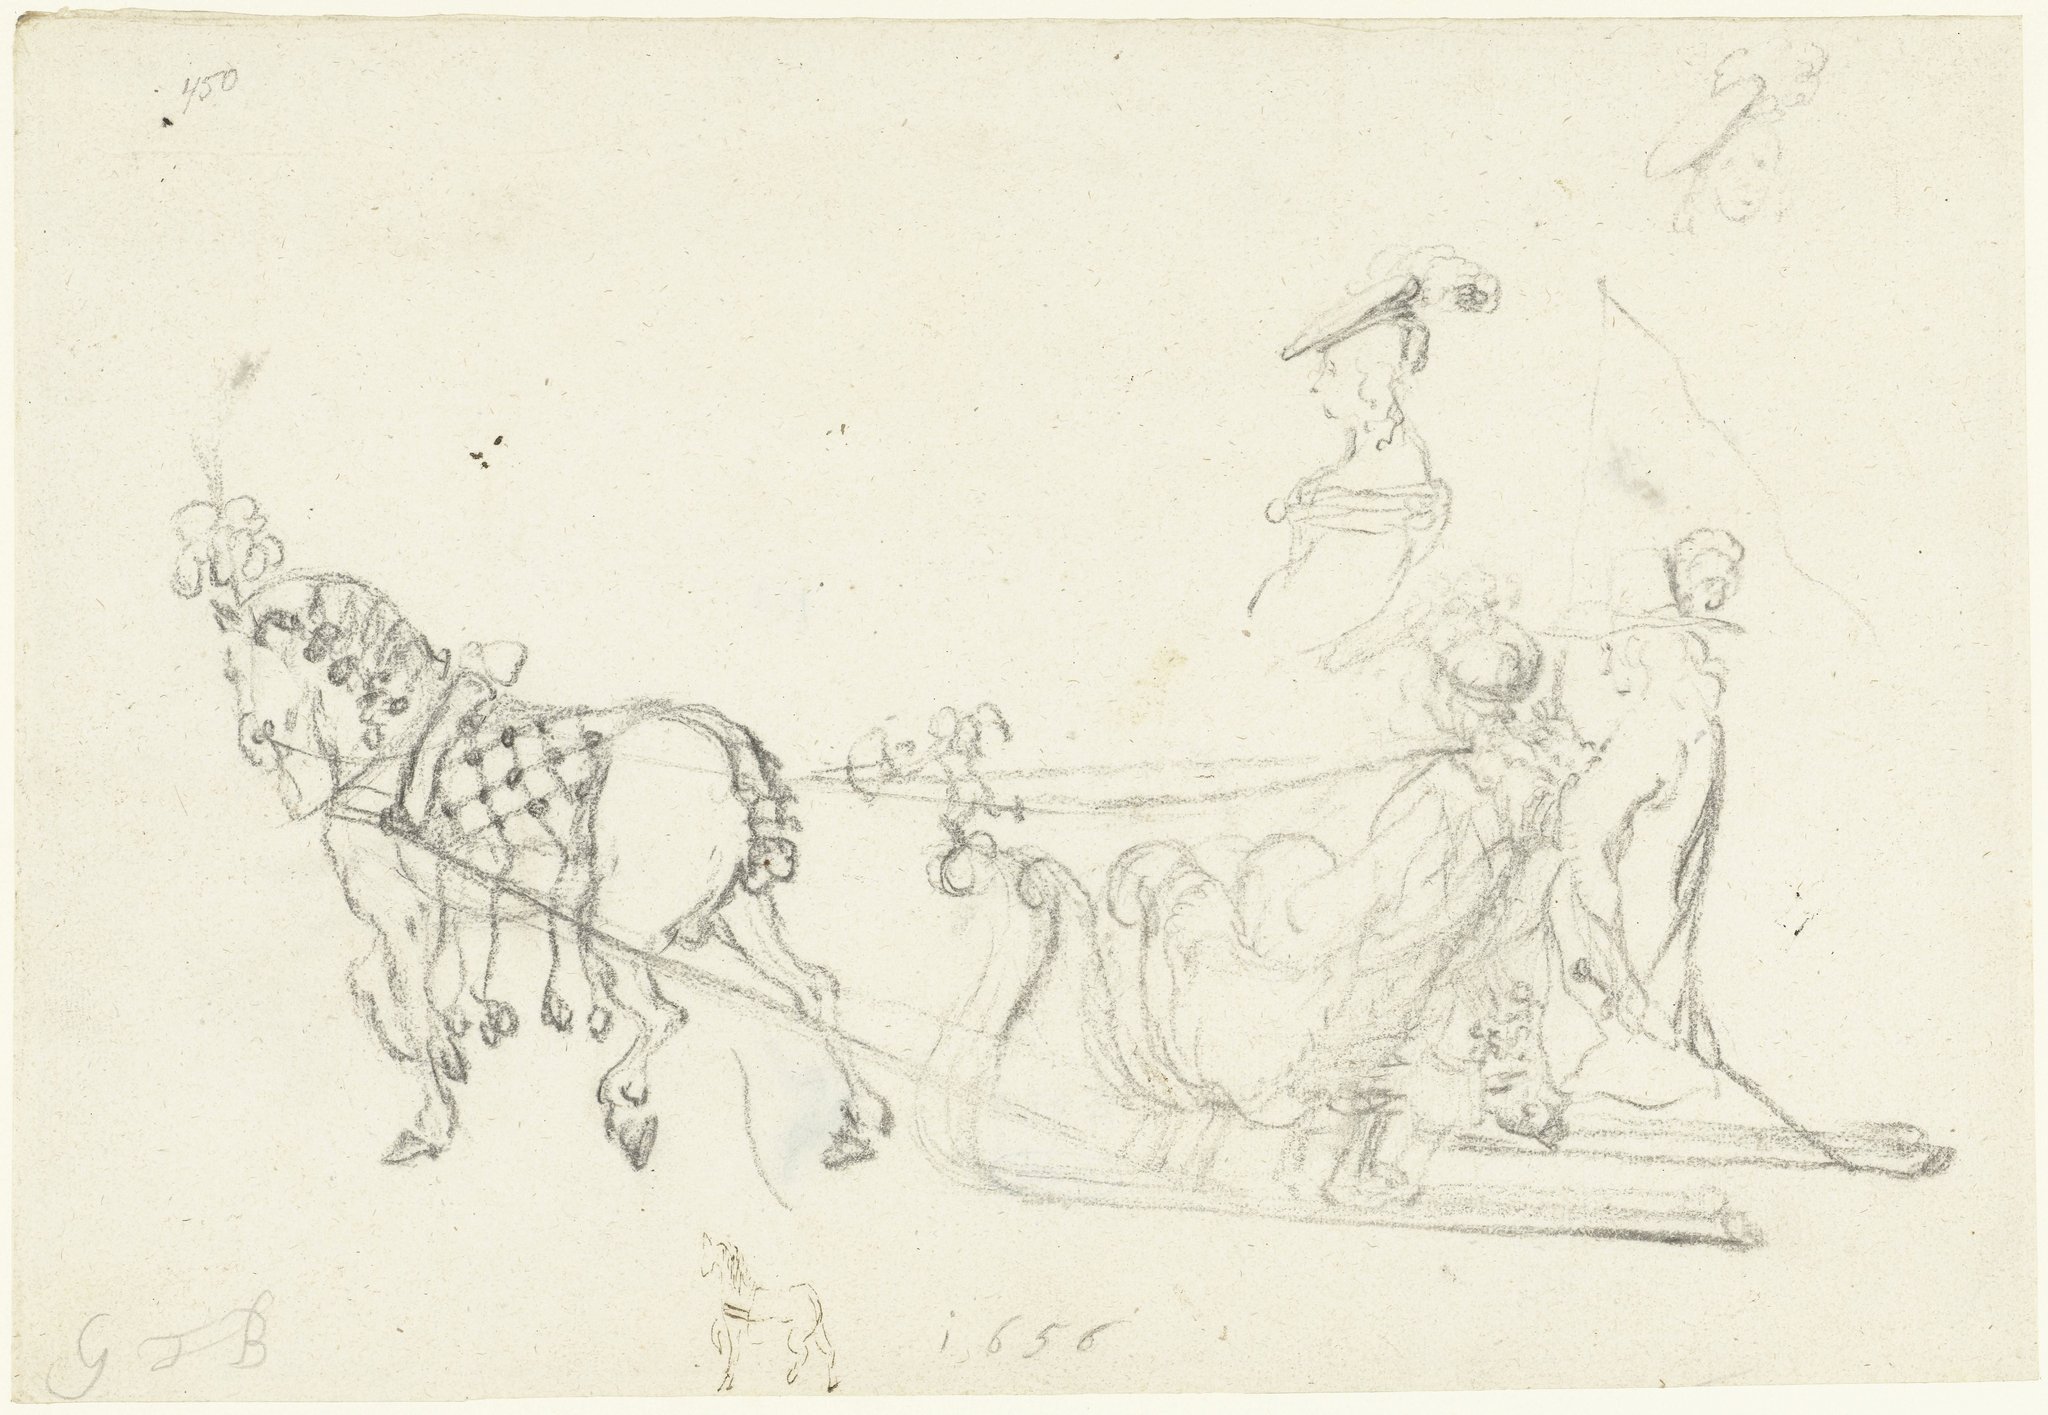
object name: drawing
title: Paard met arrenslee en een aantal schetsen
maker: gerard ter borch (ii)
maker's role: draughtsman, painter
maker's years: 1617-1681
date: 1656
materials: chalk, ink, paper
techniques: pen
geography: deventer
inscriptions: date, monogram: ‘GTB’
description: Een door een paard getrokken arrenslee, twee schetsen van het vrouwenkopje en een kindertekening van een paard.